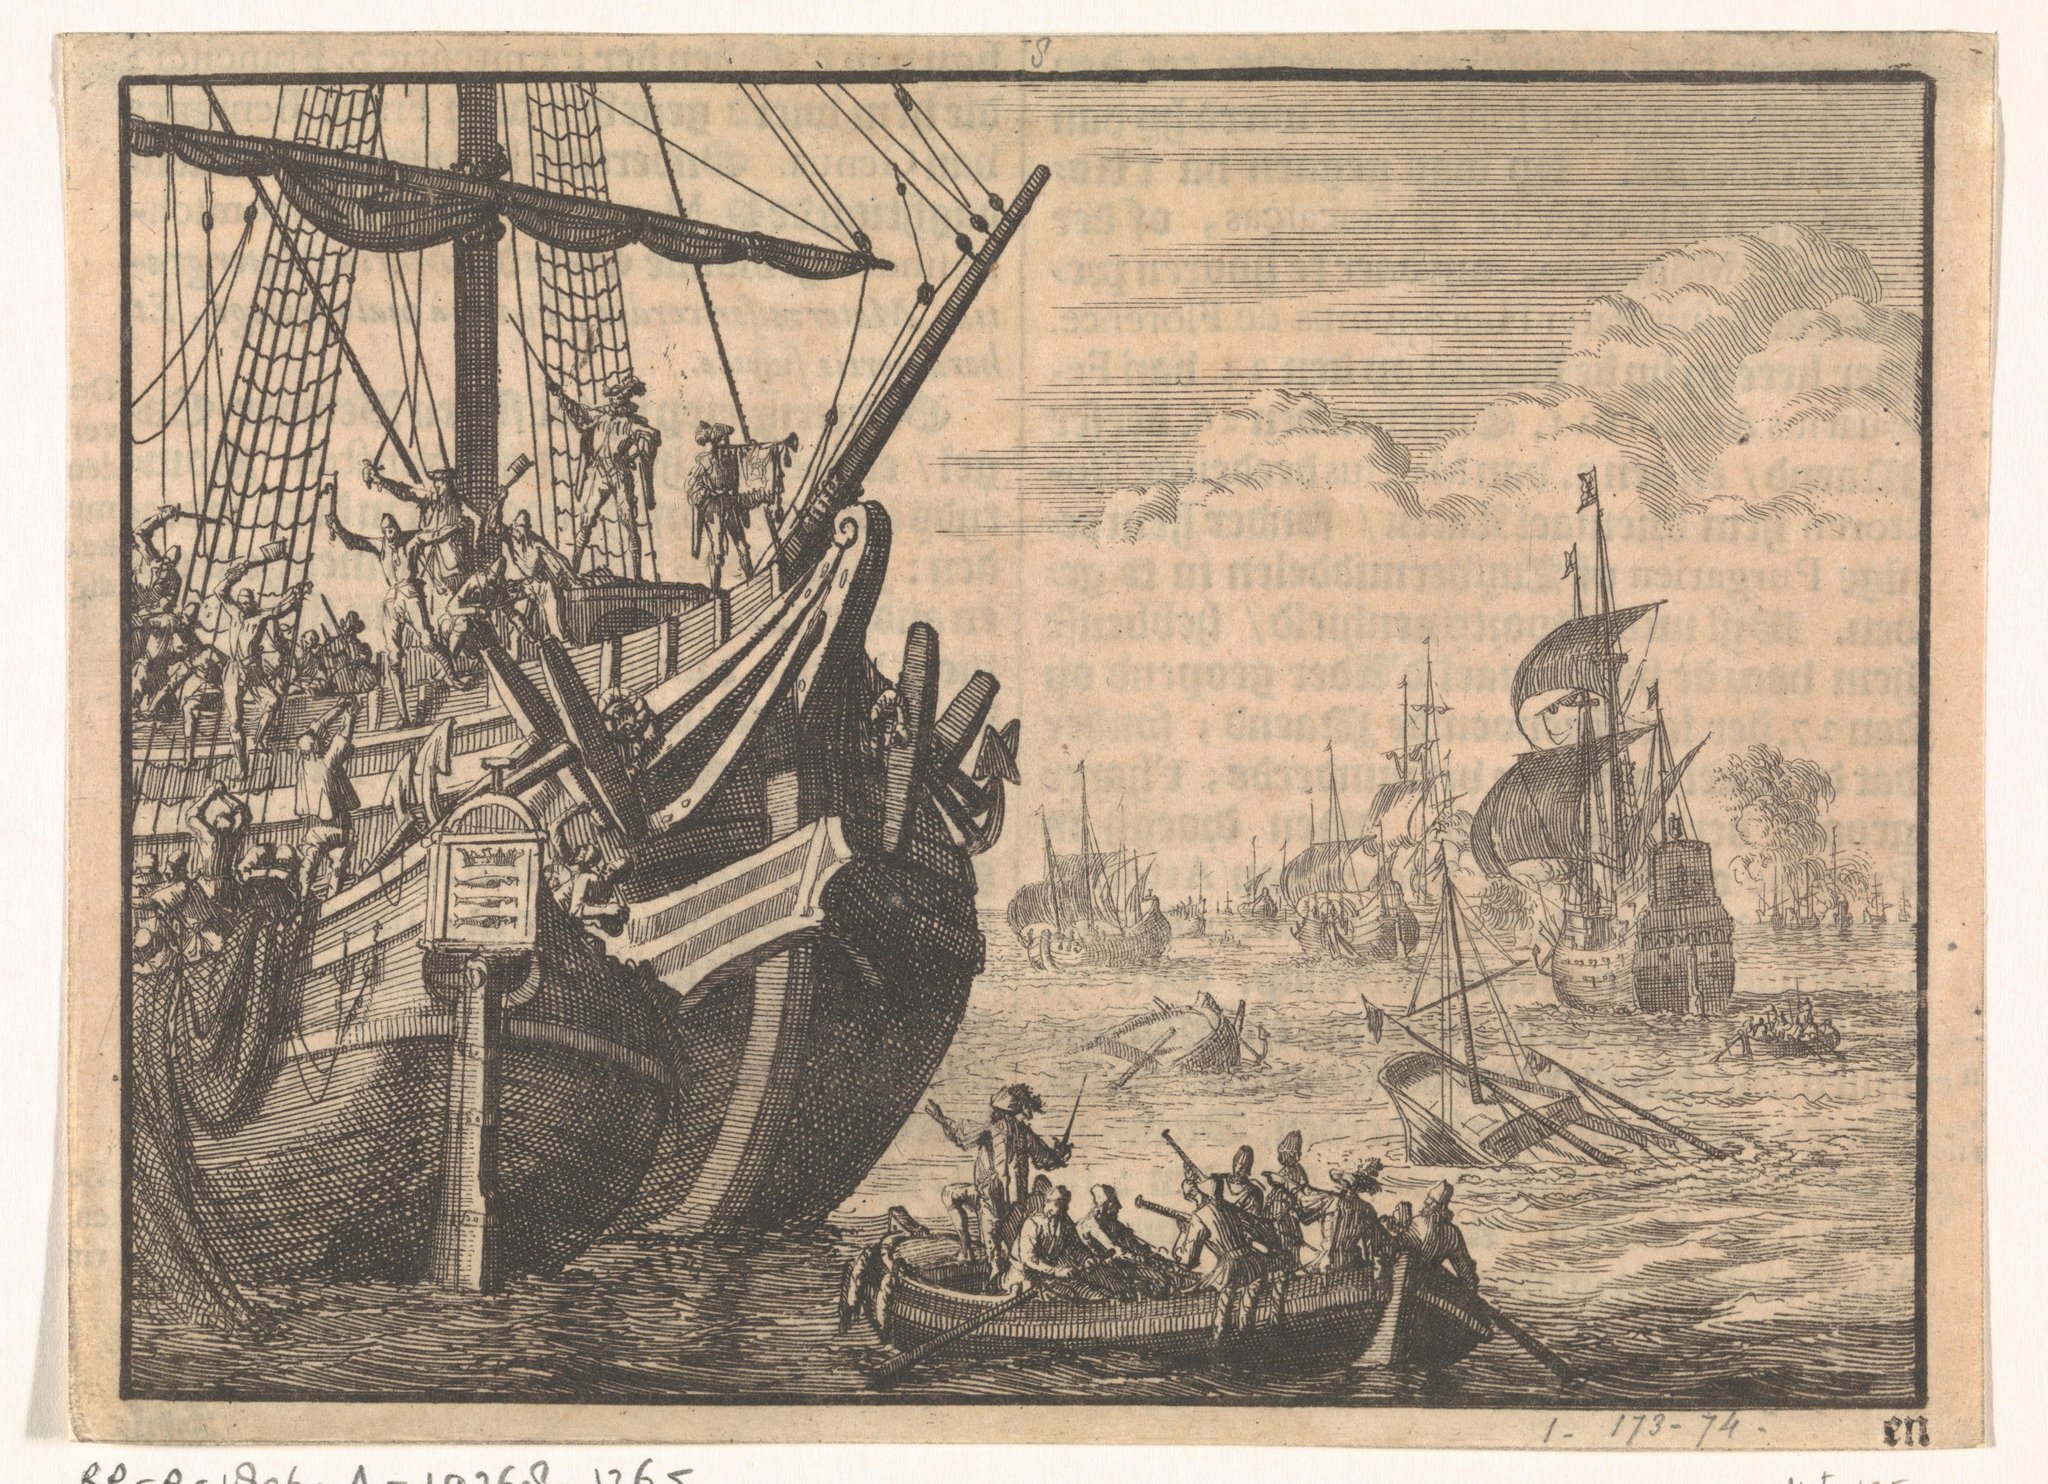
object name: print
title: Hollandse haringschepen door Spanjaarden veroverd en vernield, 1600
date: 1698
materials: paper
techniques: etching, letterpress printing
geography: leiden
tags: bony fishes: herring, sea and coastal fishery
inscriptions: collector's mark: Lugt 2228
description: Illustratie uit: Gottfried, Johann Ludwig. Historische kronyck; vervattende een (...) beschrijvingh der aldergedenckwaerdigste geschiedenissen des weerelds, van den aenvangh der scheppingh tot (...) 1576 (2 delen). Leiden: Pieter van der Aa, 1698, dl. I, p. 173.